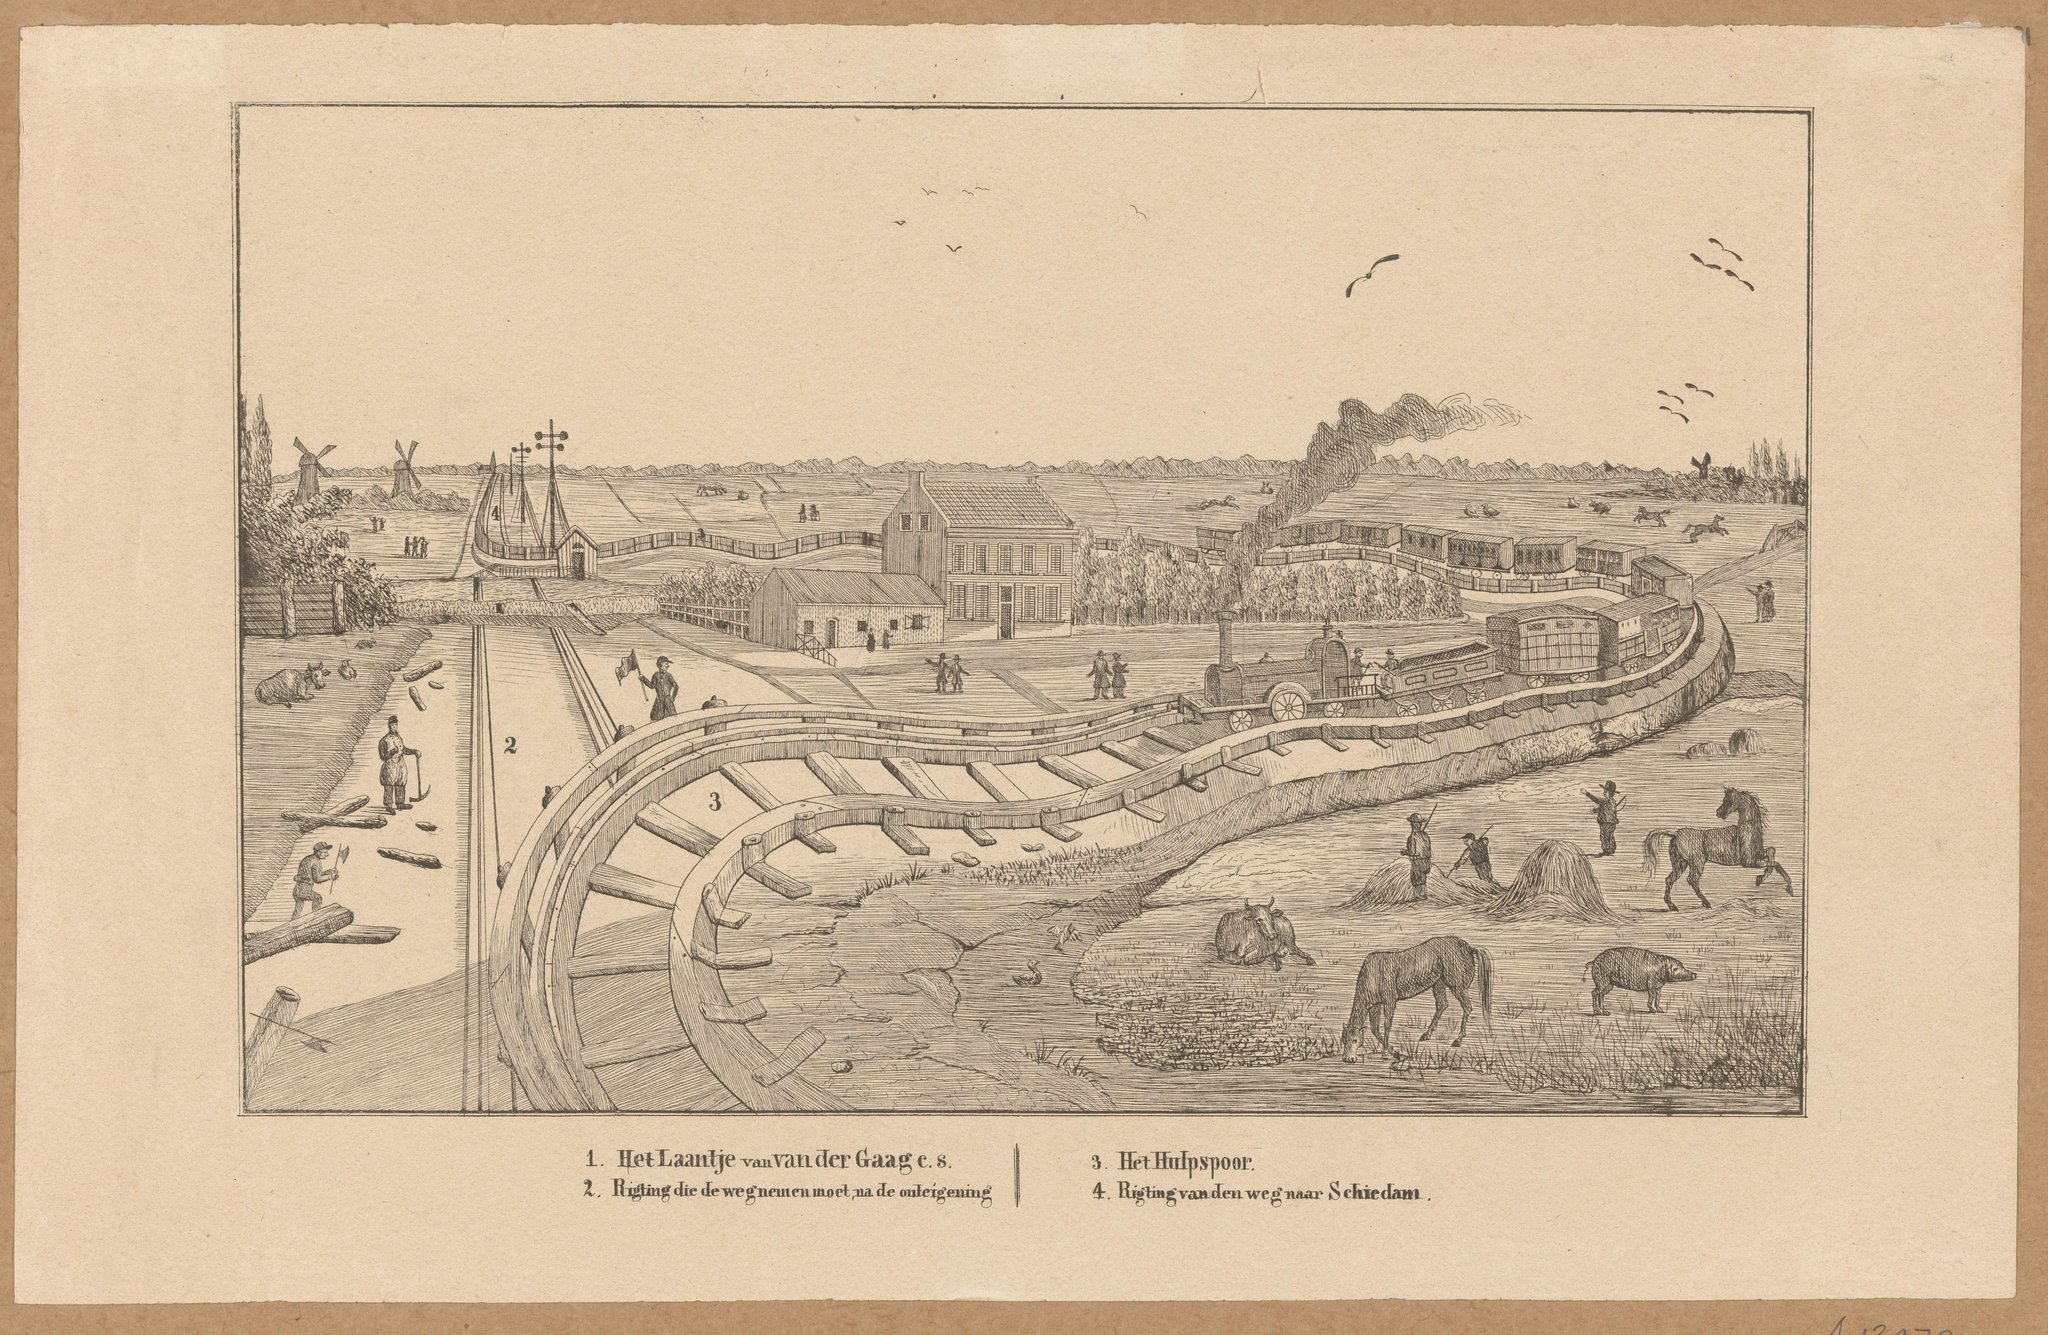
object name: print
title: Gezicht op het hulpspoor van de Hollandsche IJzeren Spoorweg-Maatschappij bij Delft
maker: Anonymous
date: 1847-1849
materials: paper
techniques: lithograph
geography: netherlands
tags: railway, train, delft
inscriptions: collector's mark: Lugt 2228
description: Gezicht op het zogenaamde Laantje van Van der Gaag, een omleiding in de spoorlijn tussen Delft en Schiedam. Omdat Van der Gaag zijn land weigerde af te staan moest de spoorlijn in een grote bocht om het perceel worden aangelegd. Aan dit geval dankt de Onteigeningswet haar oorsprong. Het proces over deze zaak werd in juni 1847 beslist.